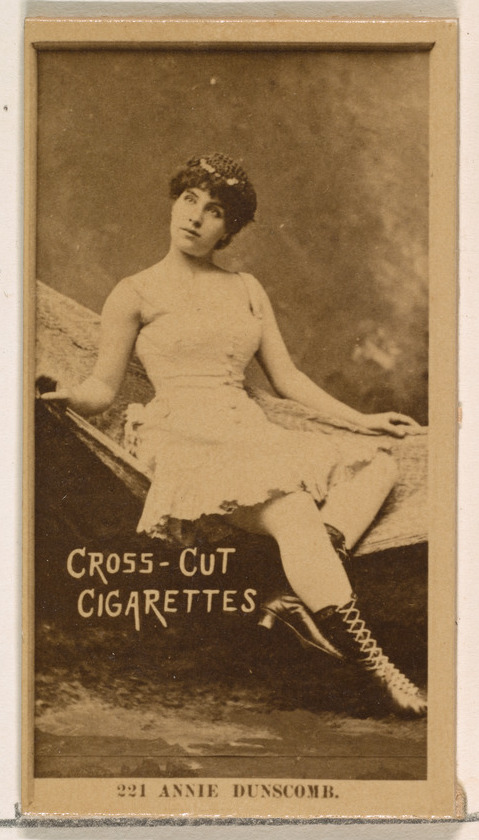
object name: print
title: Card Number 221, Annie Dunscomb, from the Actors and Actresses series (N145-2) issued by Duke Sons & Co. to promote Cross Cut Cigarettes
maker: w. duke, sons & co.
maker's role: publisher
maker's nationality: american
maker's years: 1870-1920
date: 1880-1889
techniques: albumen silver print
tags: portraits,women,actresses